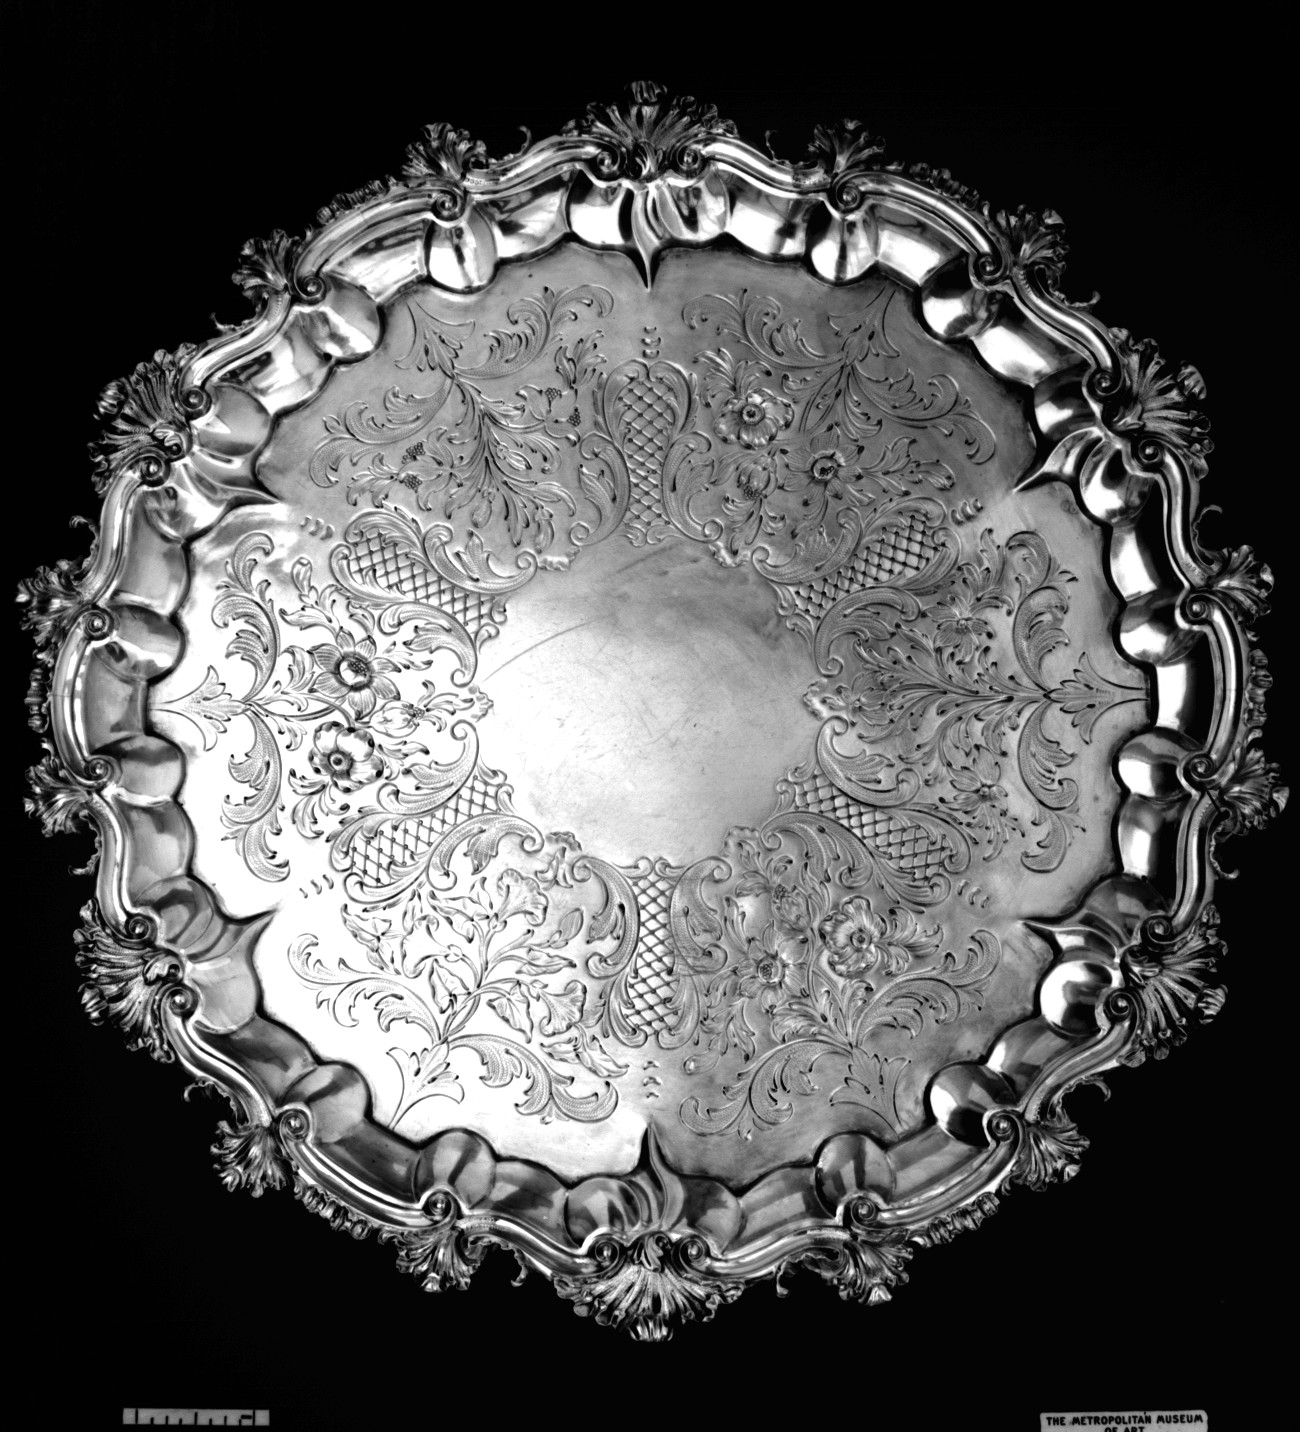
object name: salver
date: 1847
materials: silver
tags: flowers